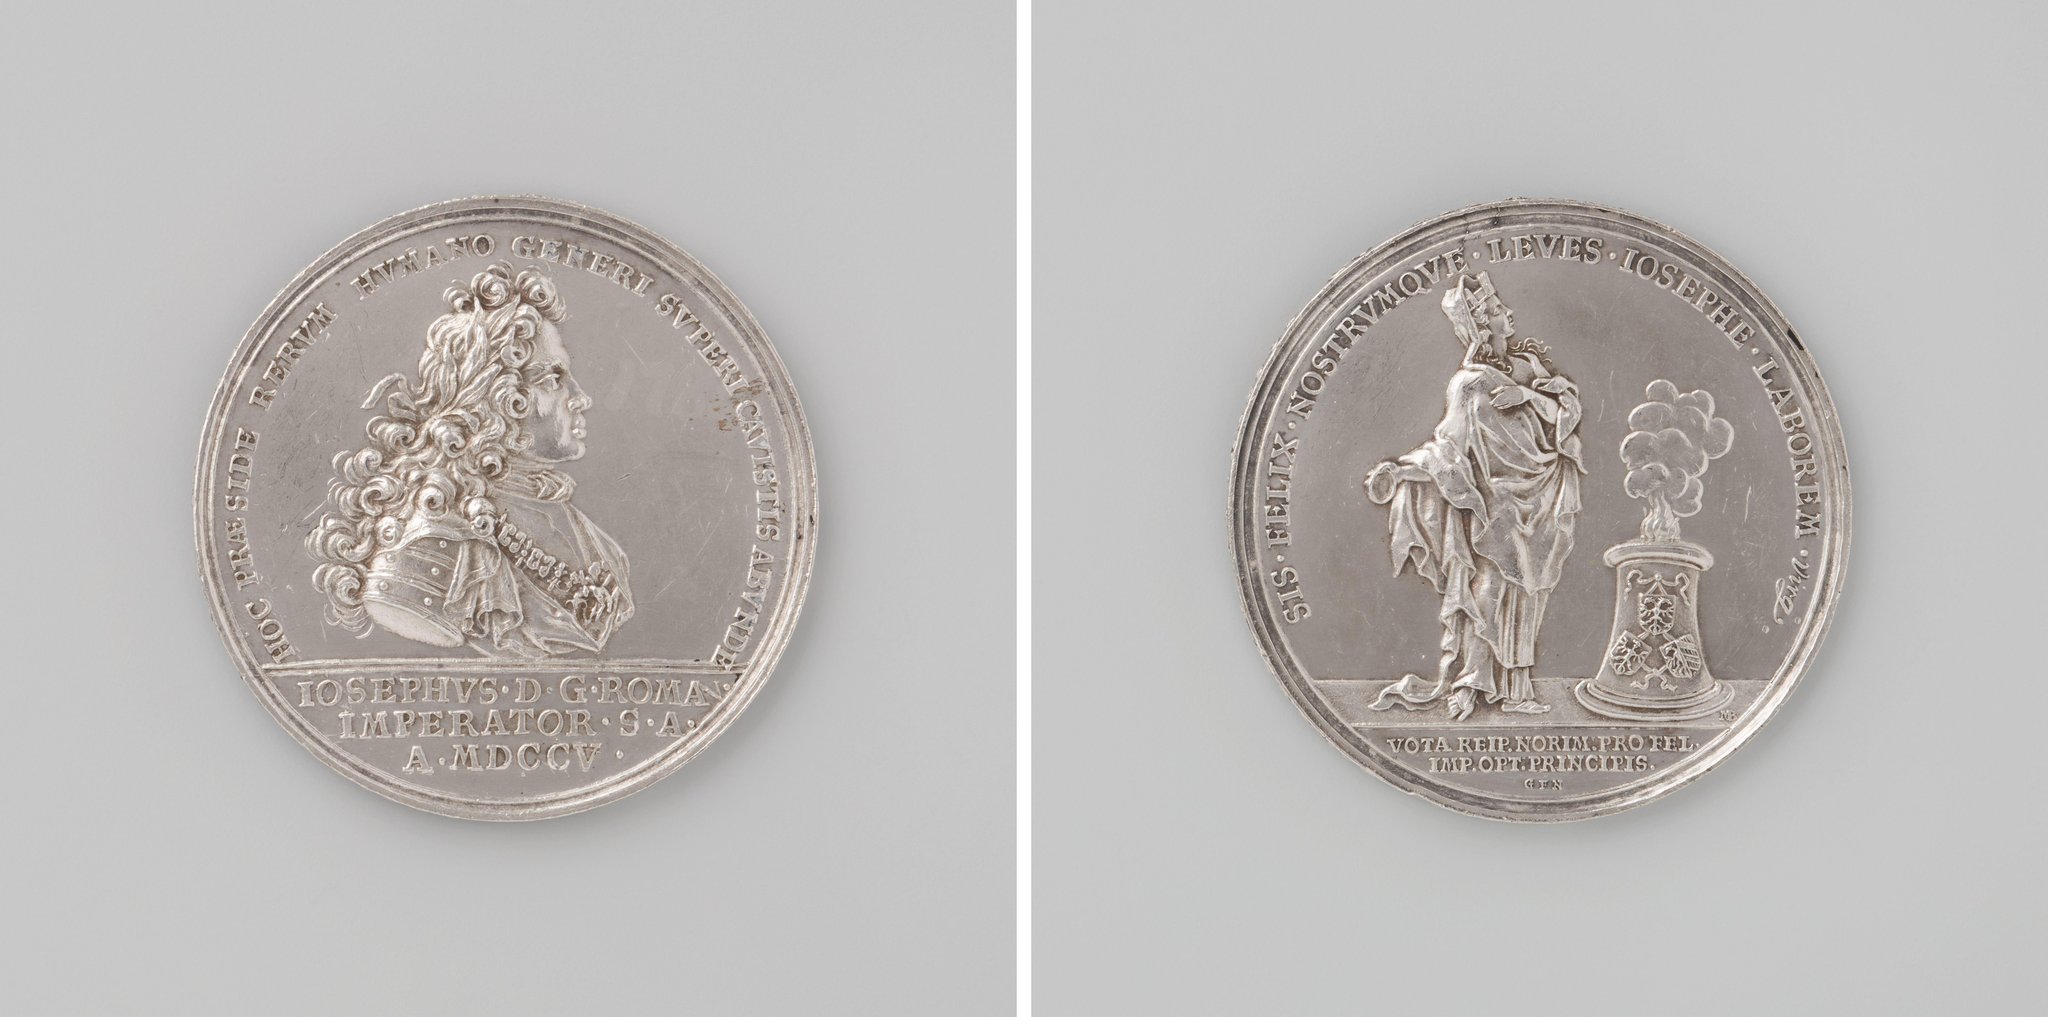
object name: history medal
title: Hulde van de stad Neurenberg aan de nieuwe Duitse keizer Jozef I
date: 1705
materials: silver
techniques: striking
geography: nuremberg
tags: vienna, jozef i (duits keizer)